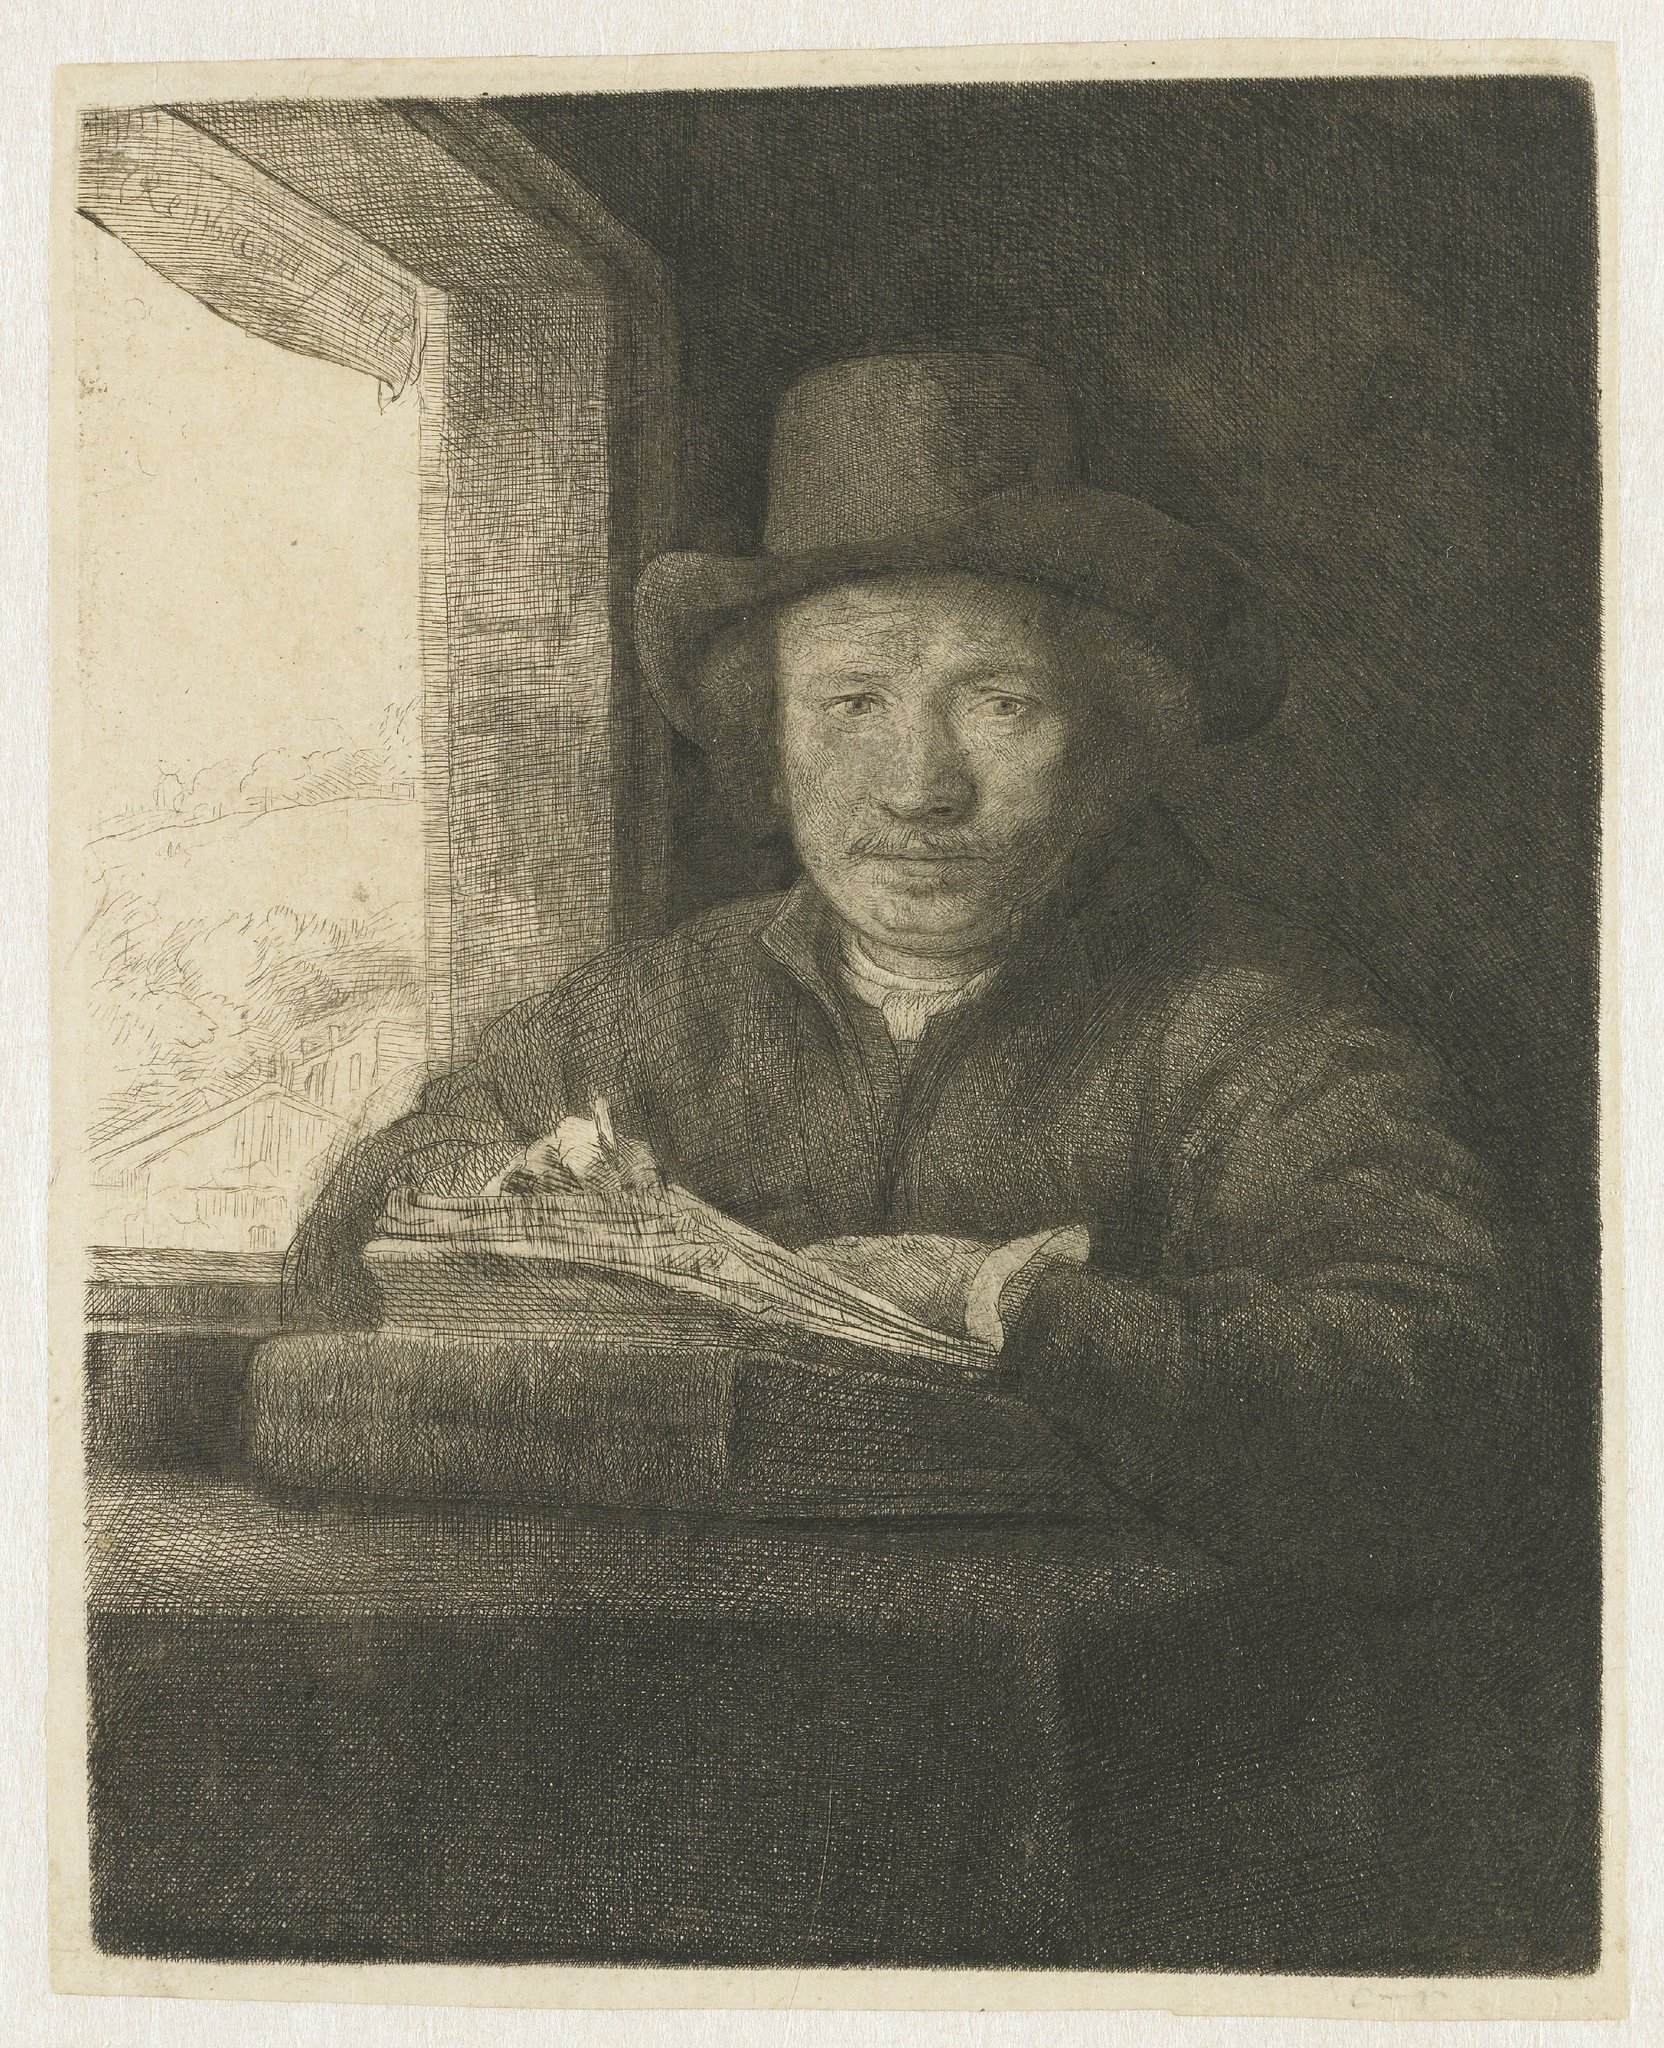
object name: print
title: Self-portrait etching at a window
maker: rembrandt van rijn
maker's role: draughtsman, painter, print maker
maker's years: 1606-1669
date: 1648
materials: paper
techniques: drypoint, etching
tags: leiden, amsterdam, painter, print maker, draughtsman, rembrandt van rijn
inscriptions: signature and date: ‘Rembrandt f. 1648’